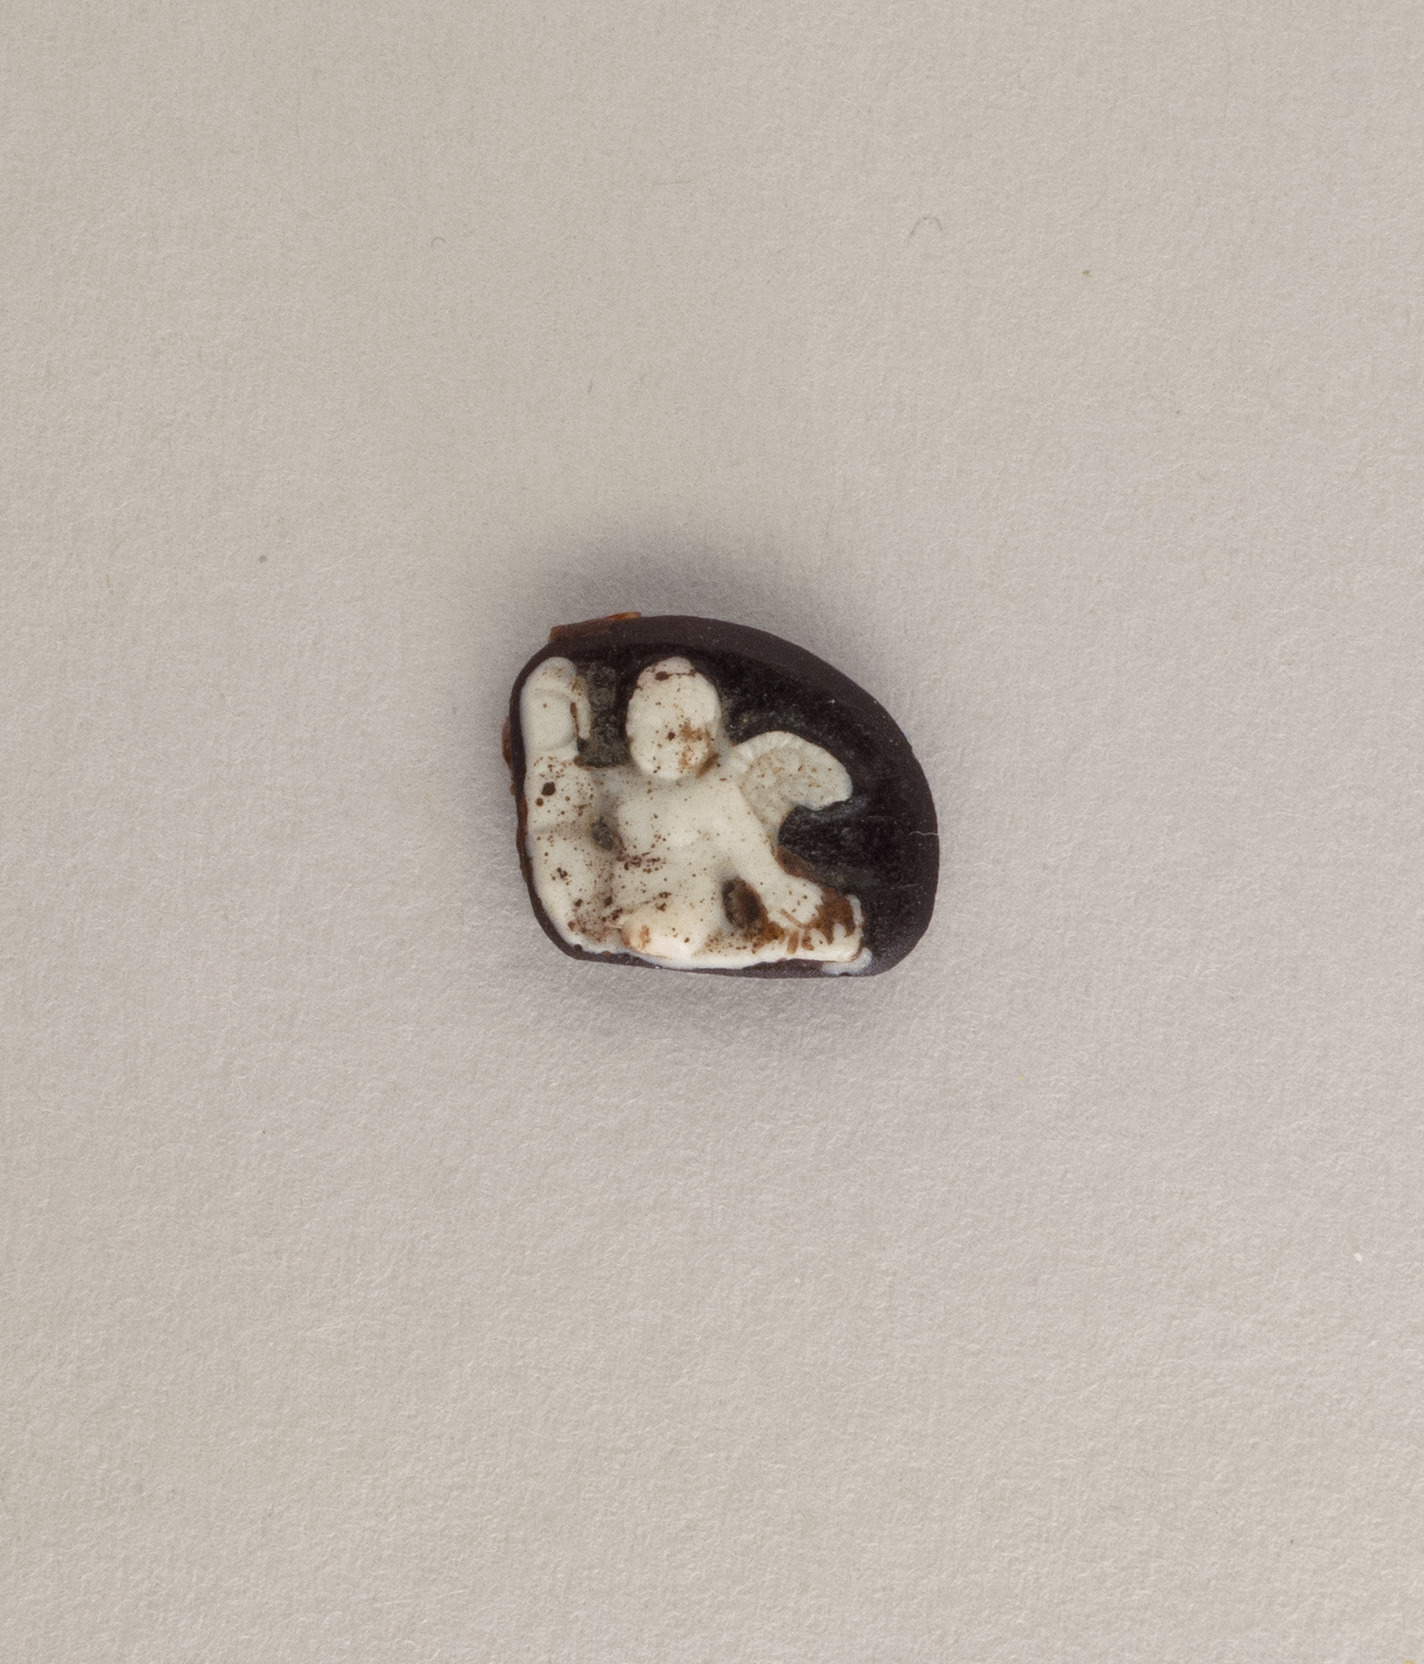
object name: cameo, cupid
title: Glass cameo with cupid (Eros)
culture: roman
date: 1-100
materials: glass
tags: cupid